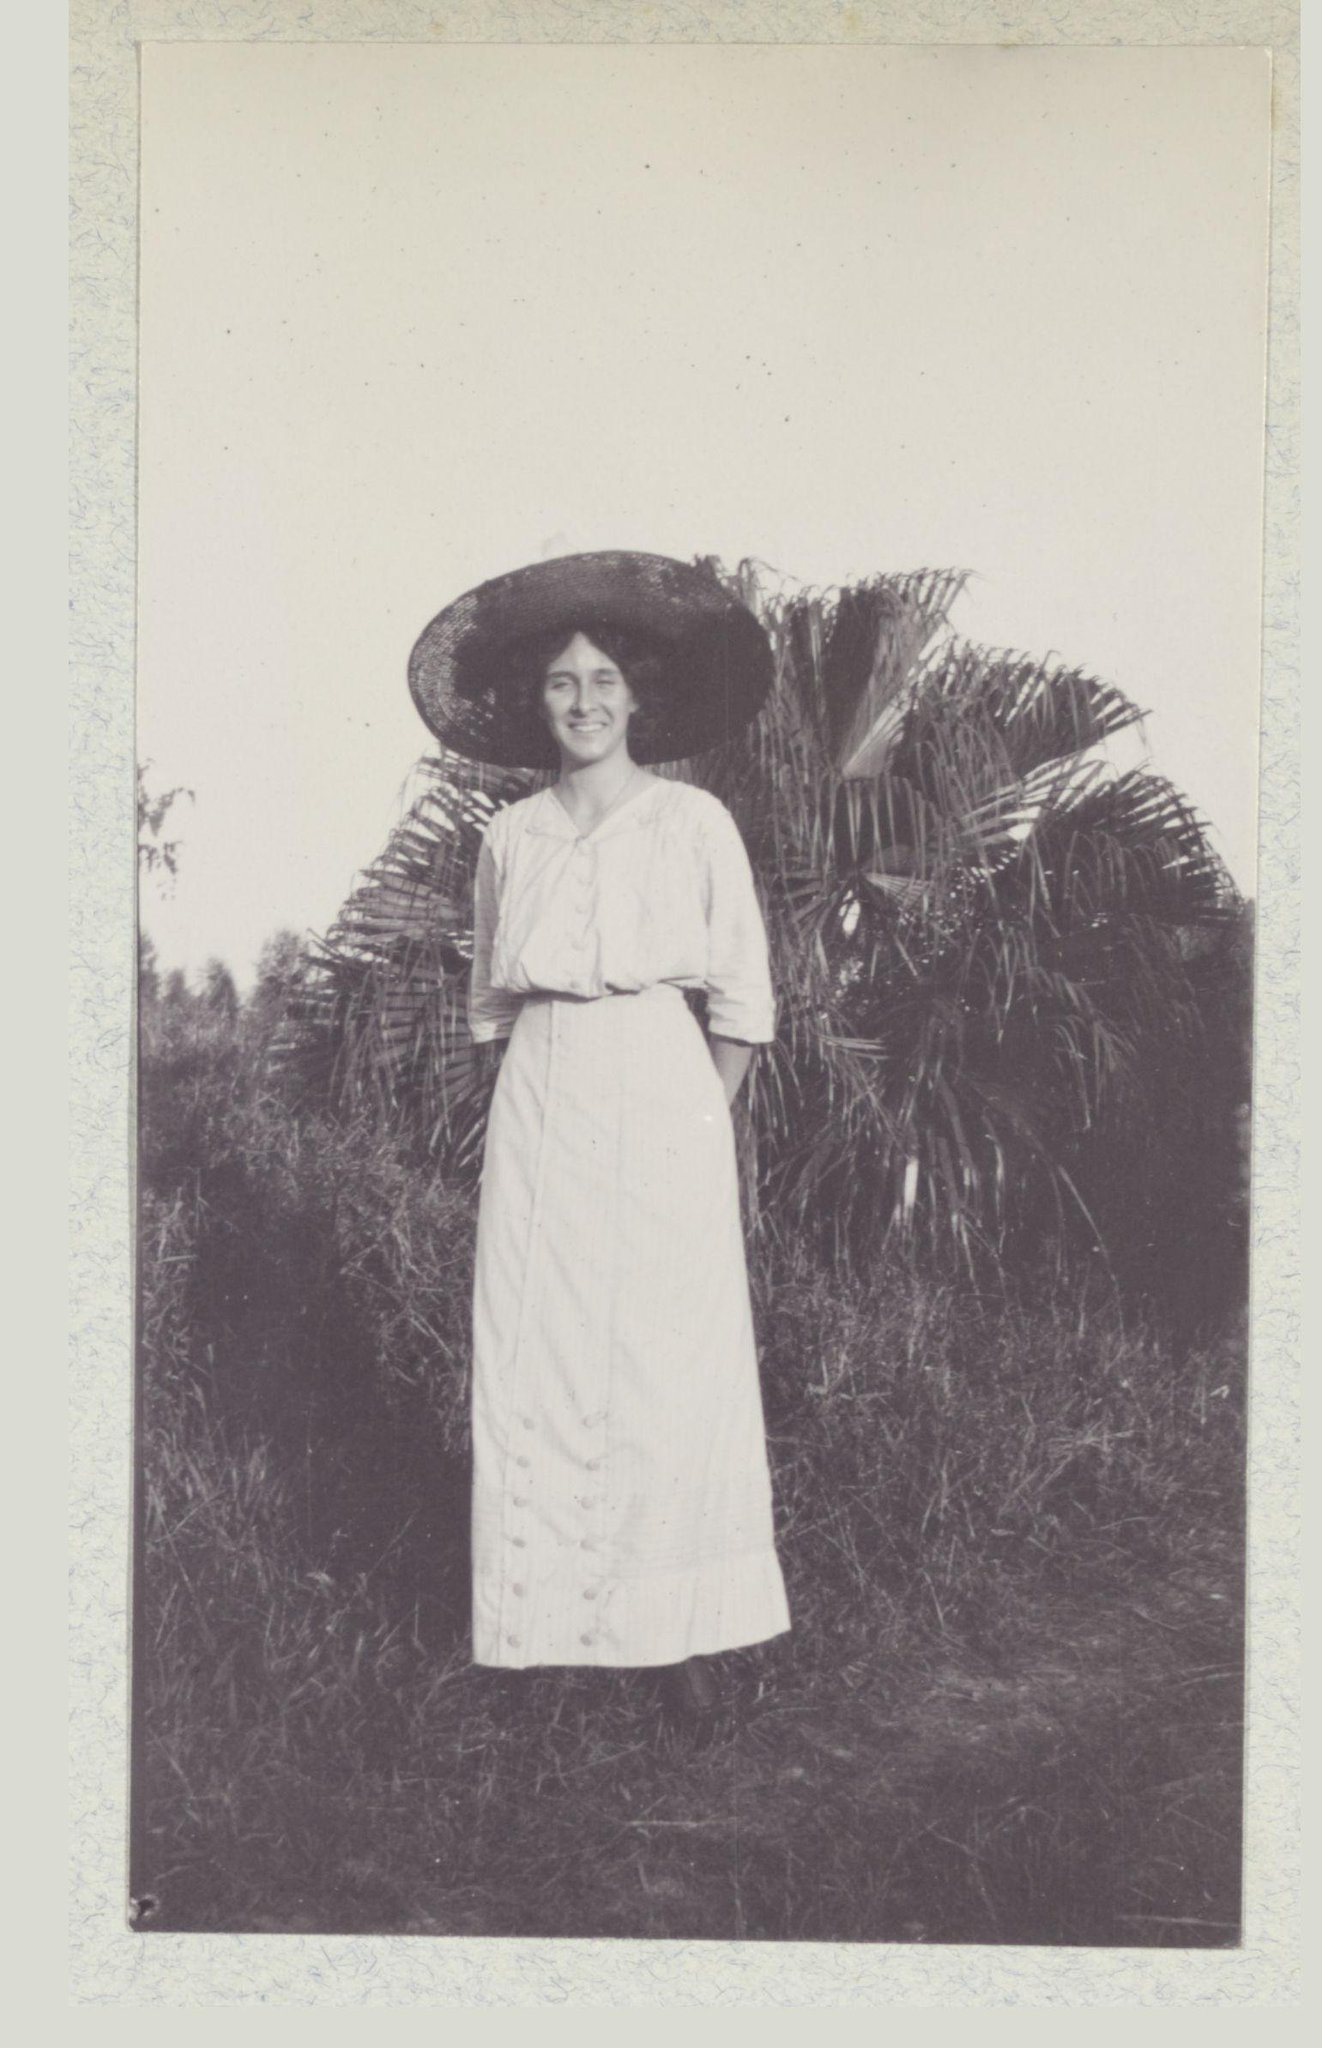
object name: photograph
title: Maria Gonggrijp met een grote hoed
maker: andries augustus boom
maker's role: amateurfotograaf, handelaar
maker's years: 1878-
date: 1911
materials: photographic support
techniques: photography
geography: suriname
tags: suriname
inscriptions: date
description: Maria Gonggrijp poserend lachend met een grote hoed op het hoofd, 1911. Onderdeel van het fotoalbum van de familie Boom-Gonggrijp in Suriname en Curaçao.